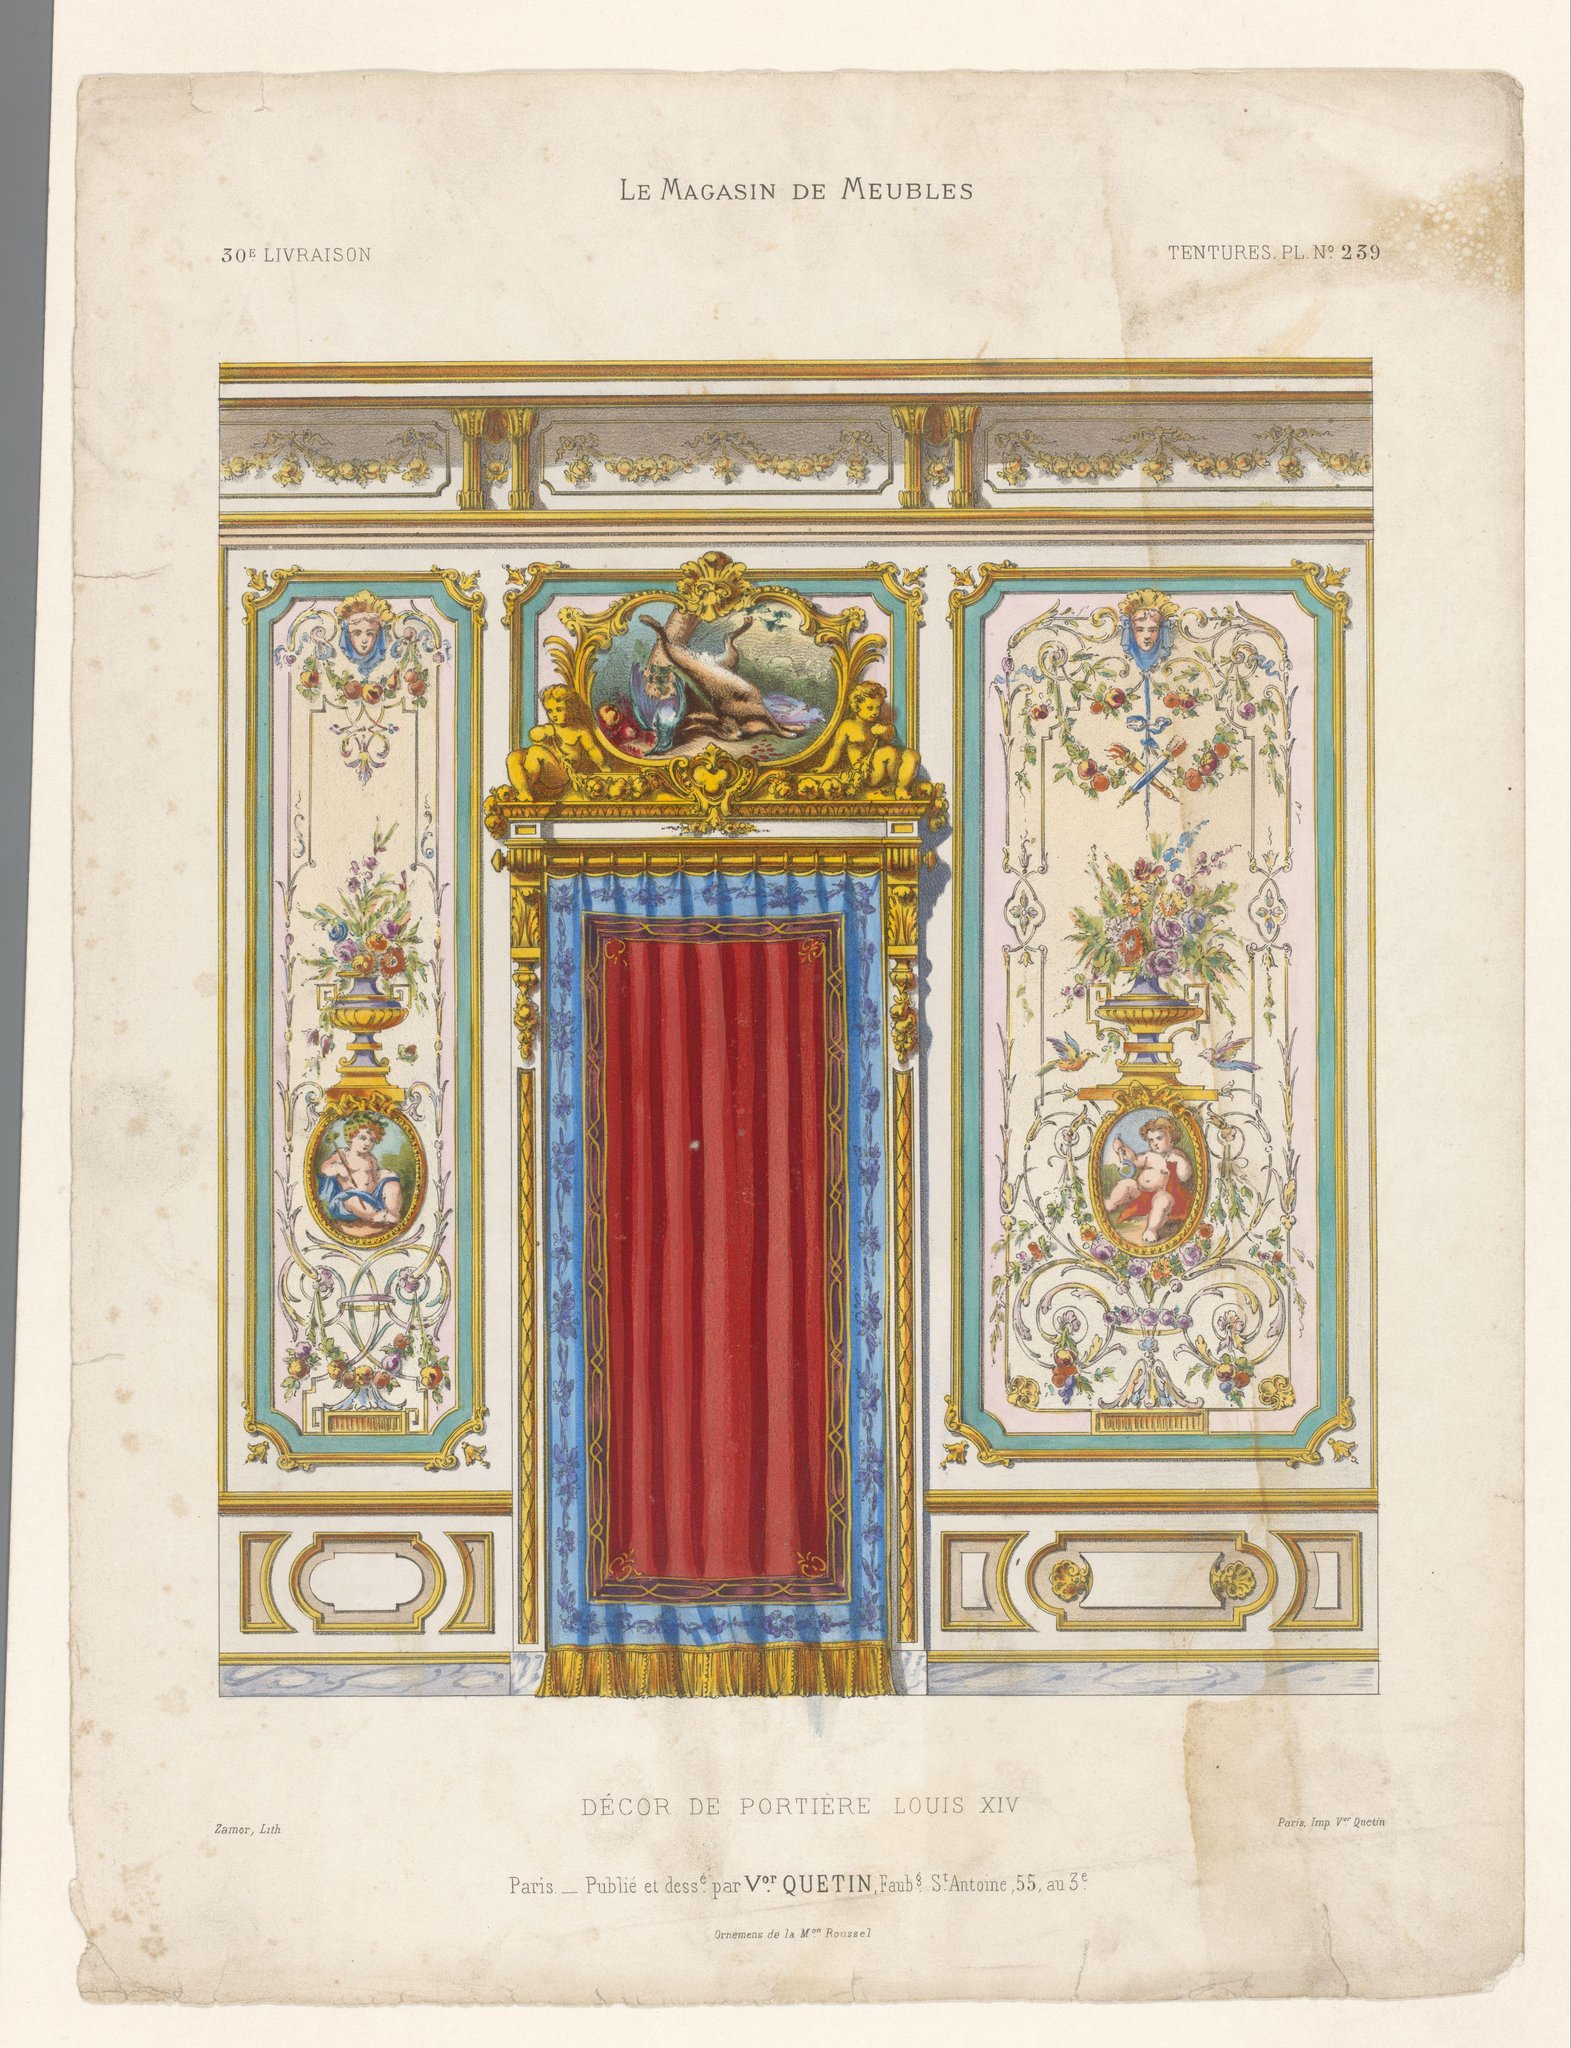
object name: print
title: Deur met gordijnen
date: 1832-1877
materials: paper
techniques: hand coloring, lithograph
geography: paris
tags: door, hangings and drapery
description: Een deur met gedrapeerde gordijnen in de Lodewijk XIV-stijl. Prent uit 30e Livraison.